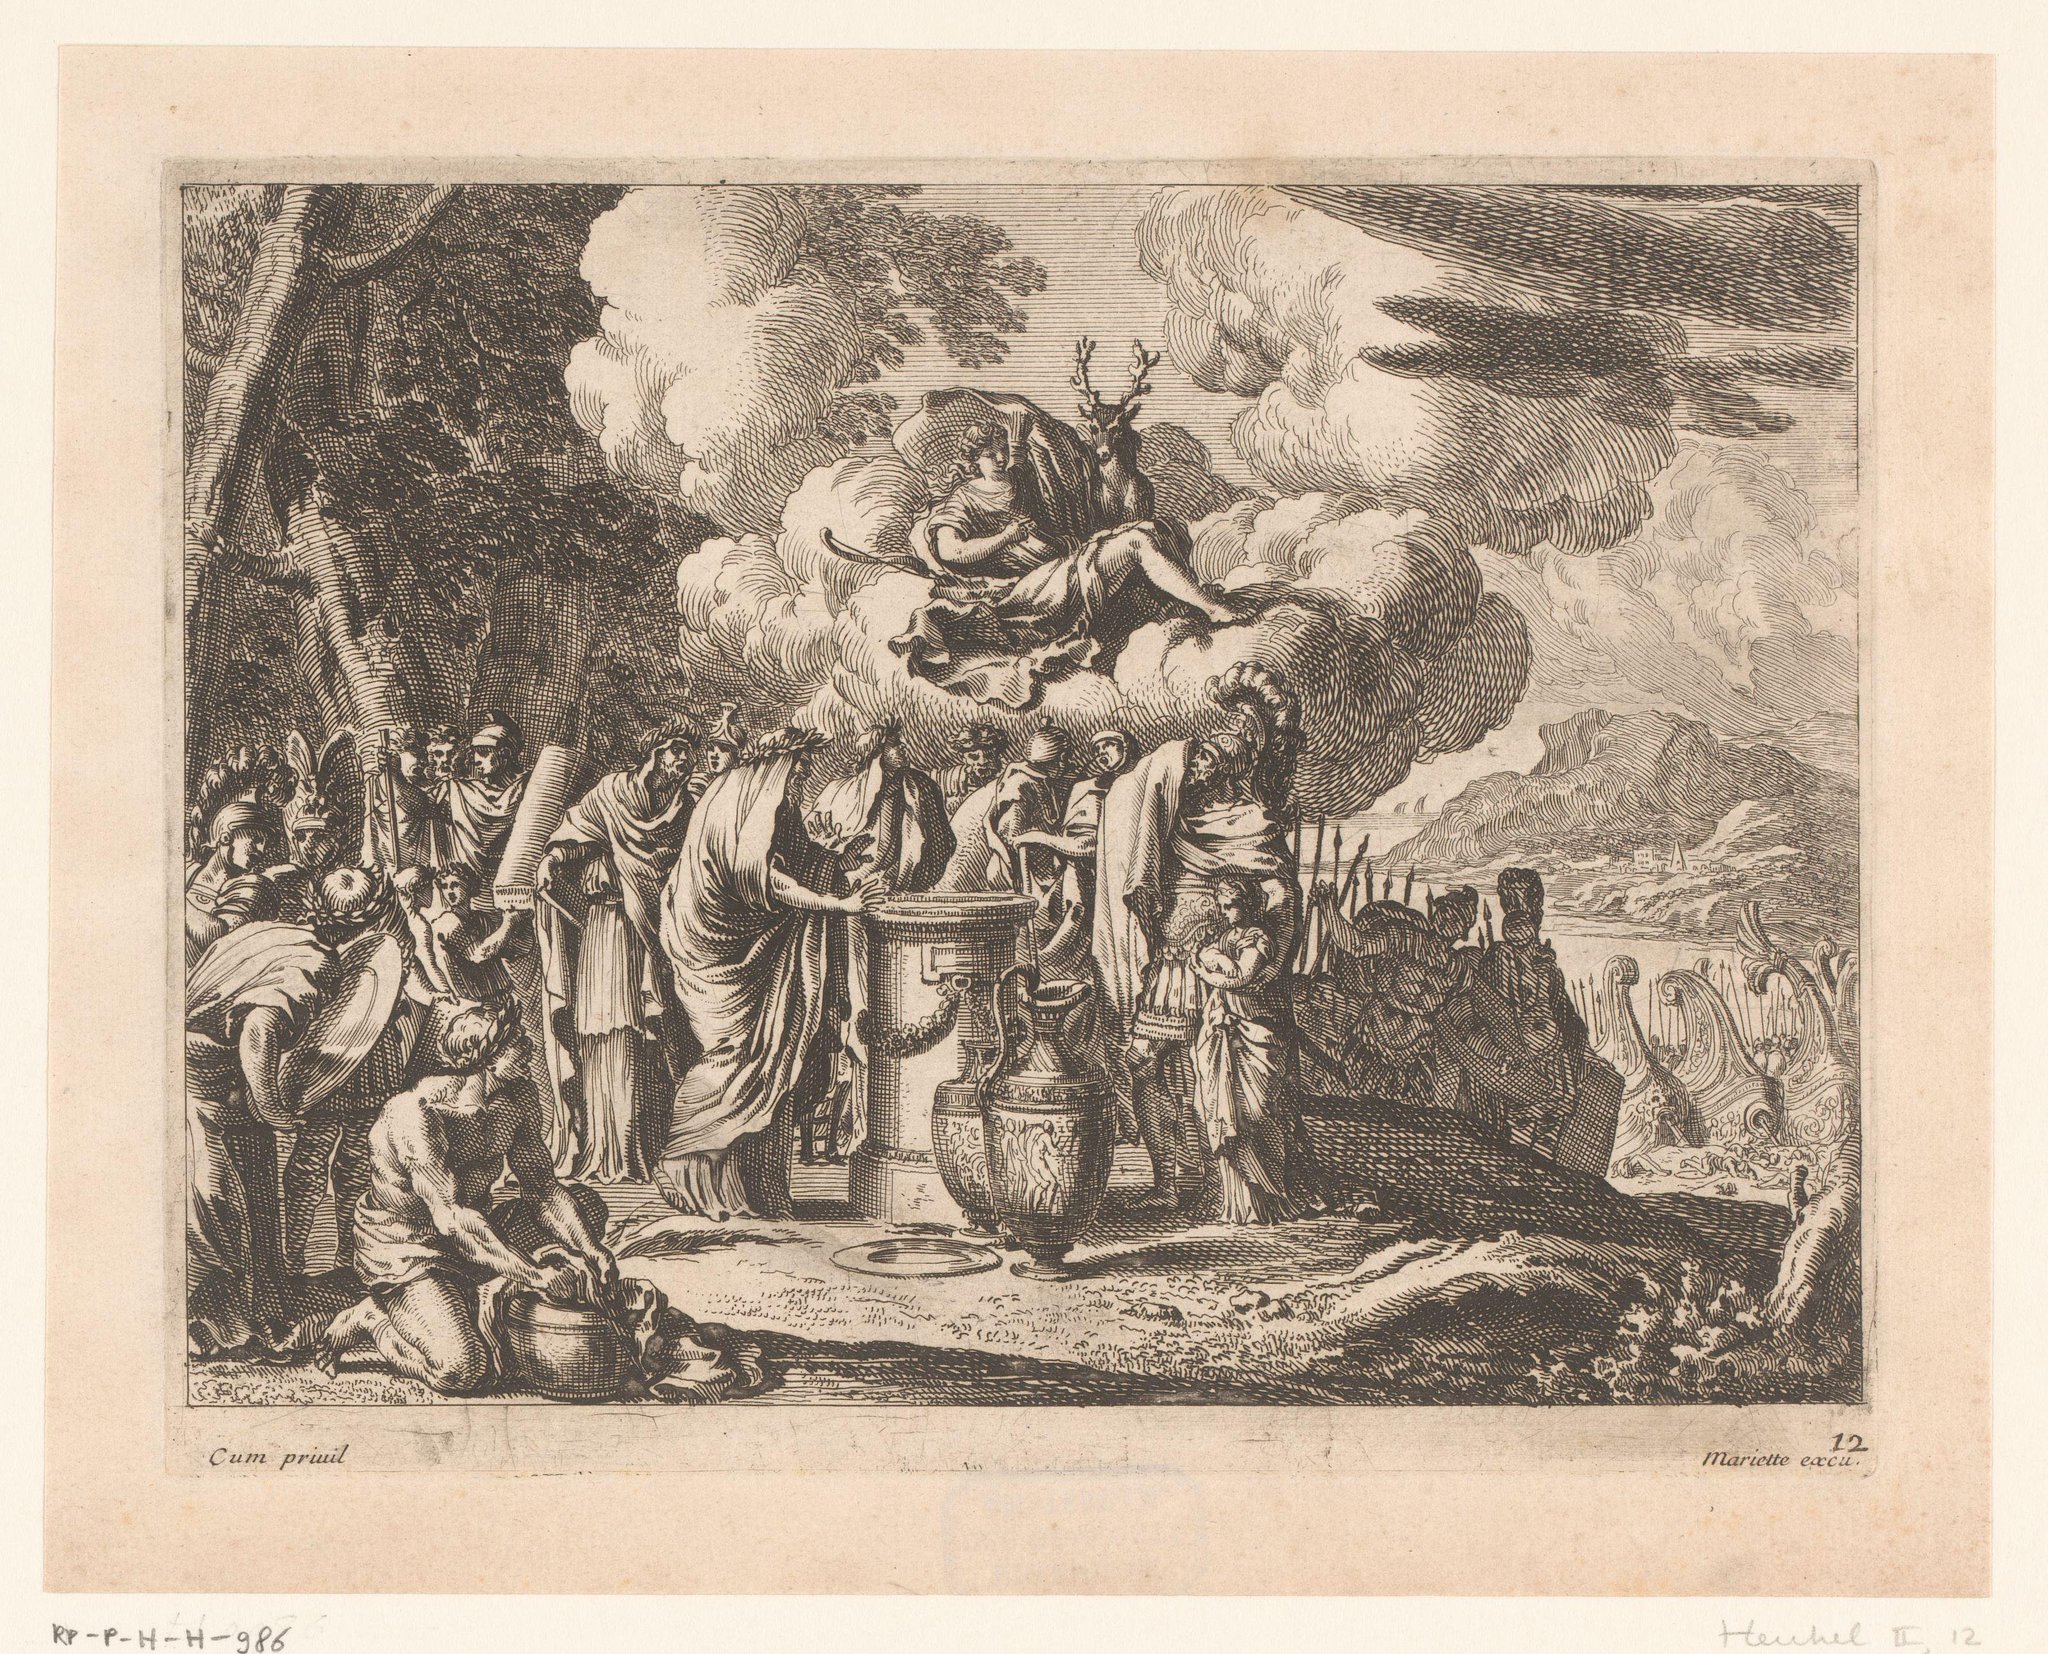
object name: print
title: Offer van Iphigeneia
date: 1628-1682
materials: paper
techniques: etching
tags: iphigenia is saved by diana, who puts a stag (hind) in her place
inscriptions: collector's mark: Lugt 11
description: Maakt deel uit van een twintigdelige serie met mythologische scènes.